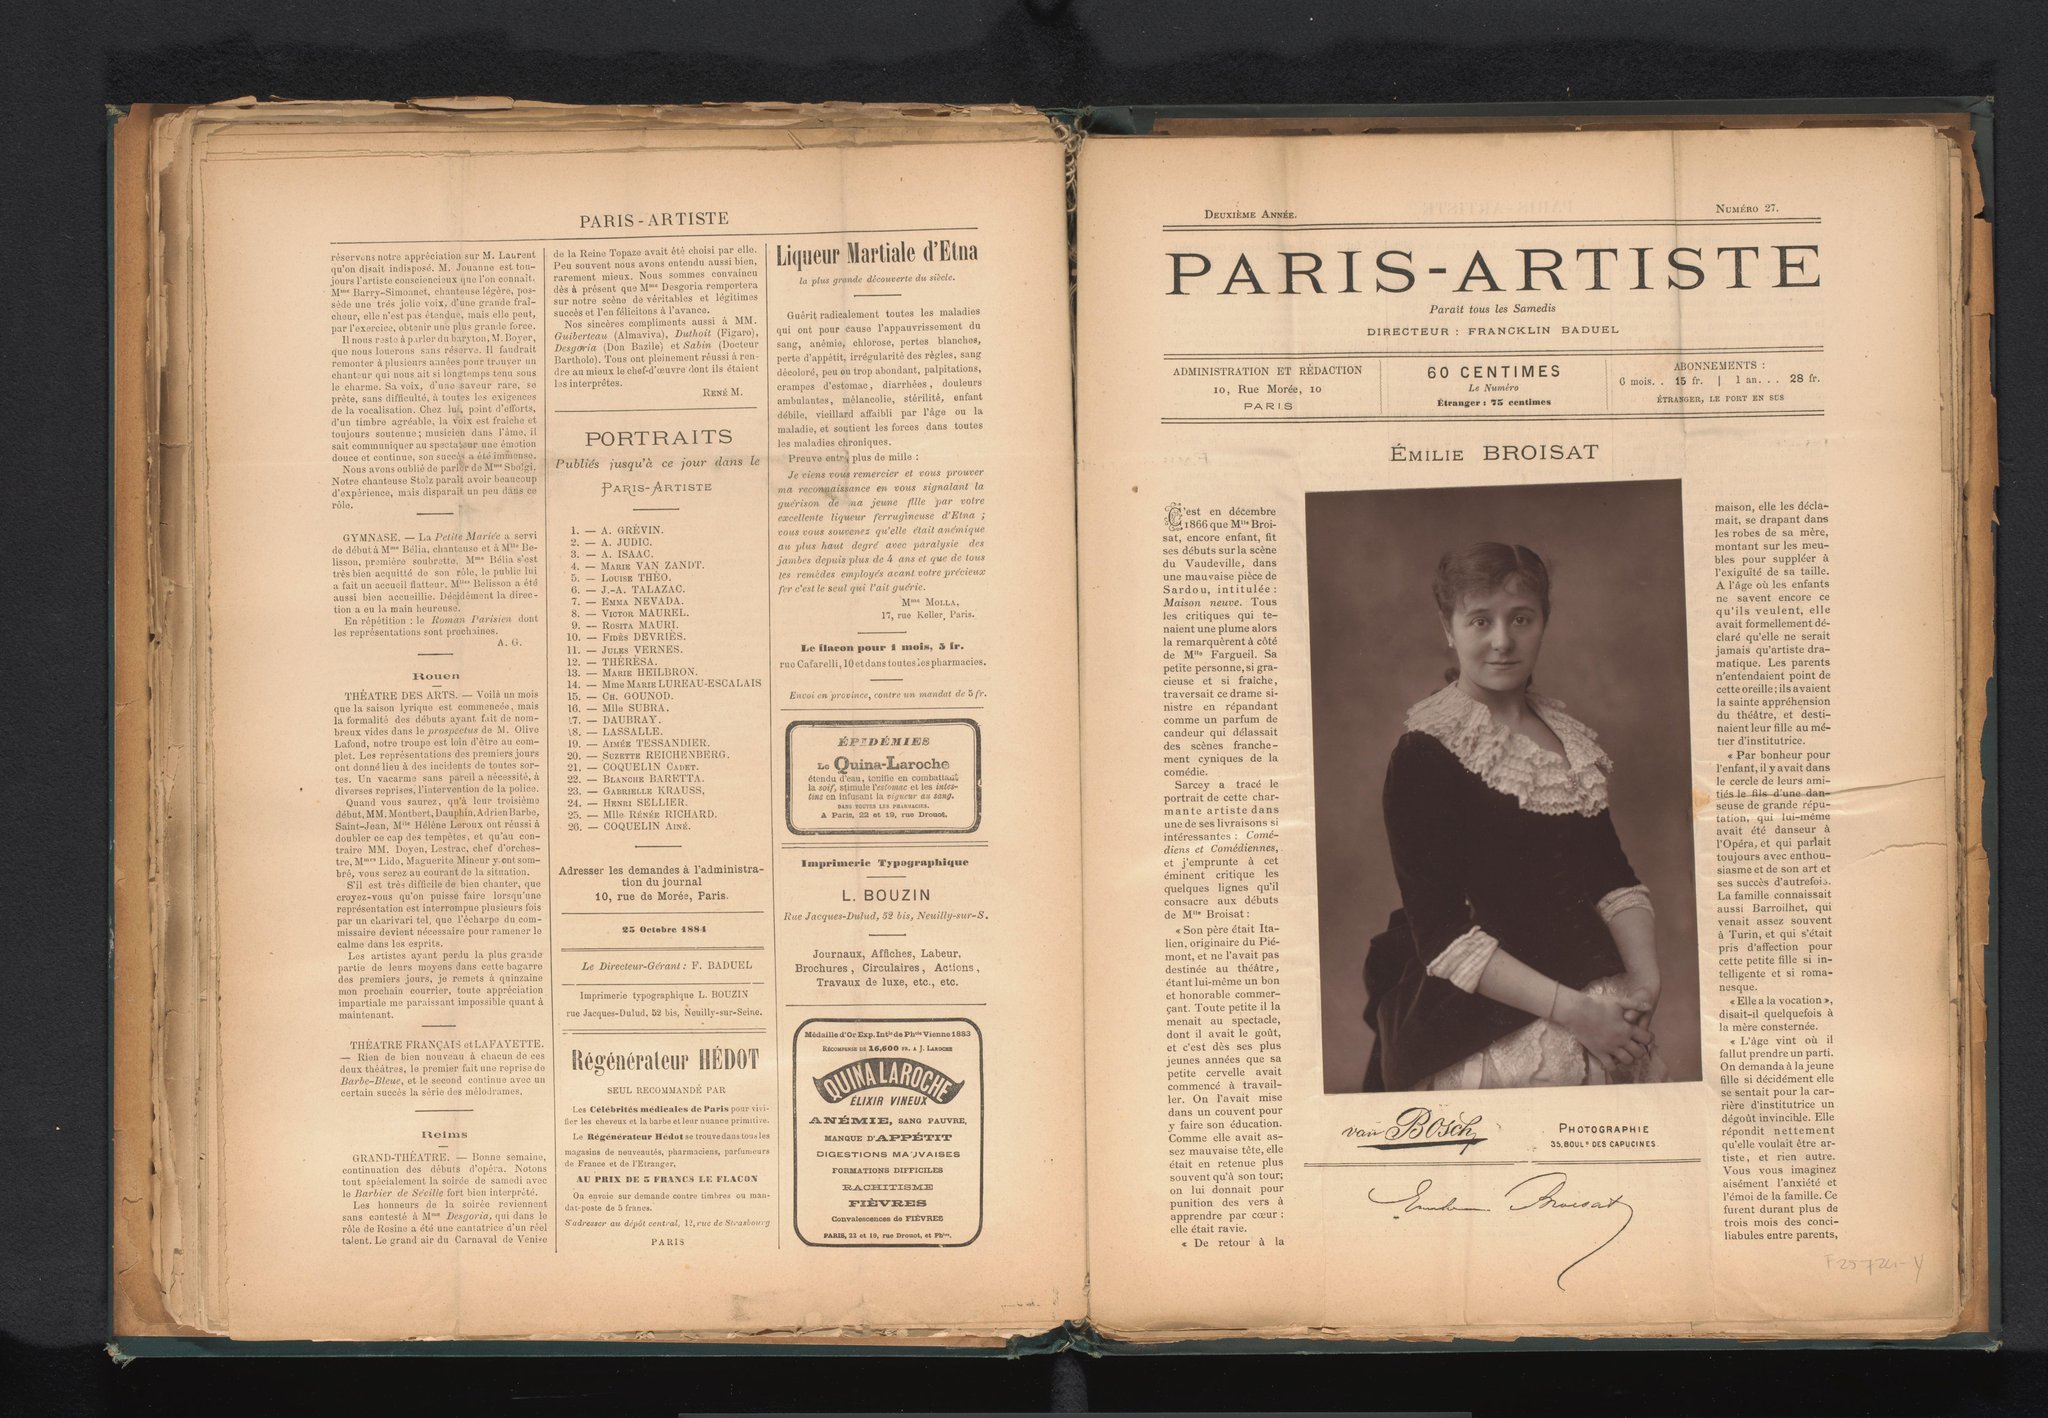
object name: page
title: Portret van Émilie Broisat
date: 1880-1884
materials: paper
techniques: woodburytype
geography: paris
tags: historical persons - bb - woman, portrait of actor, actress